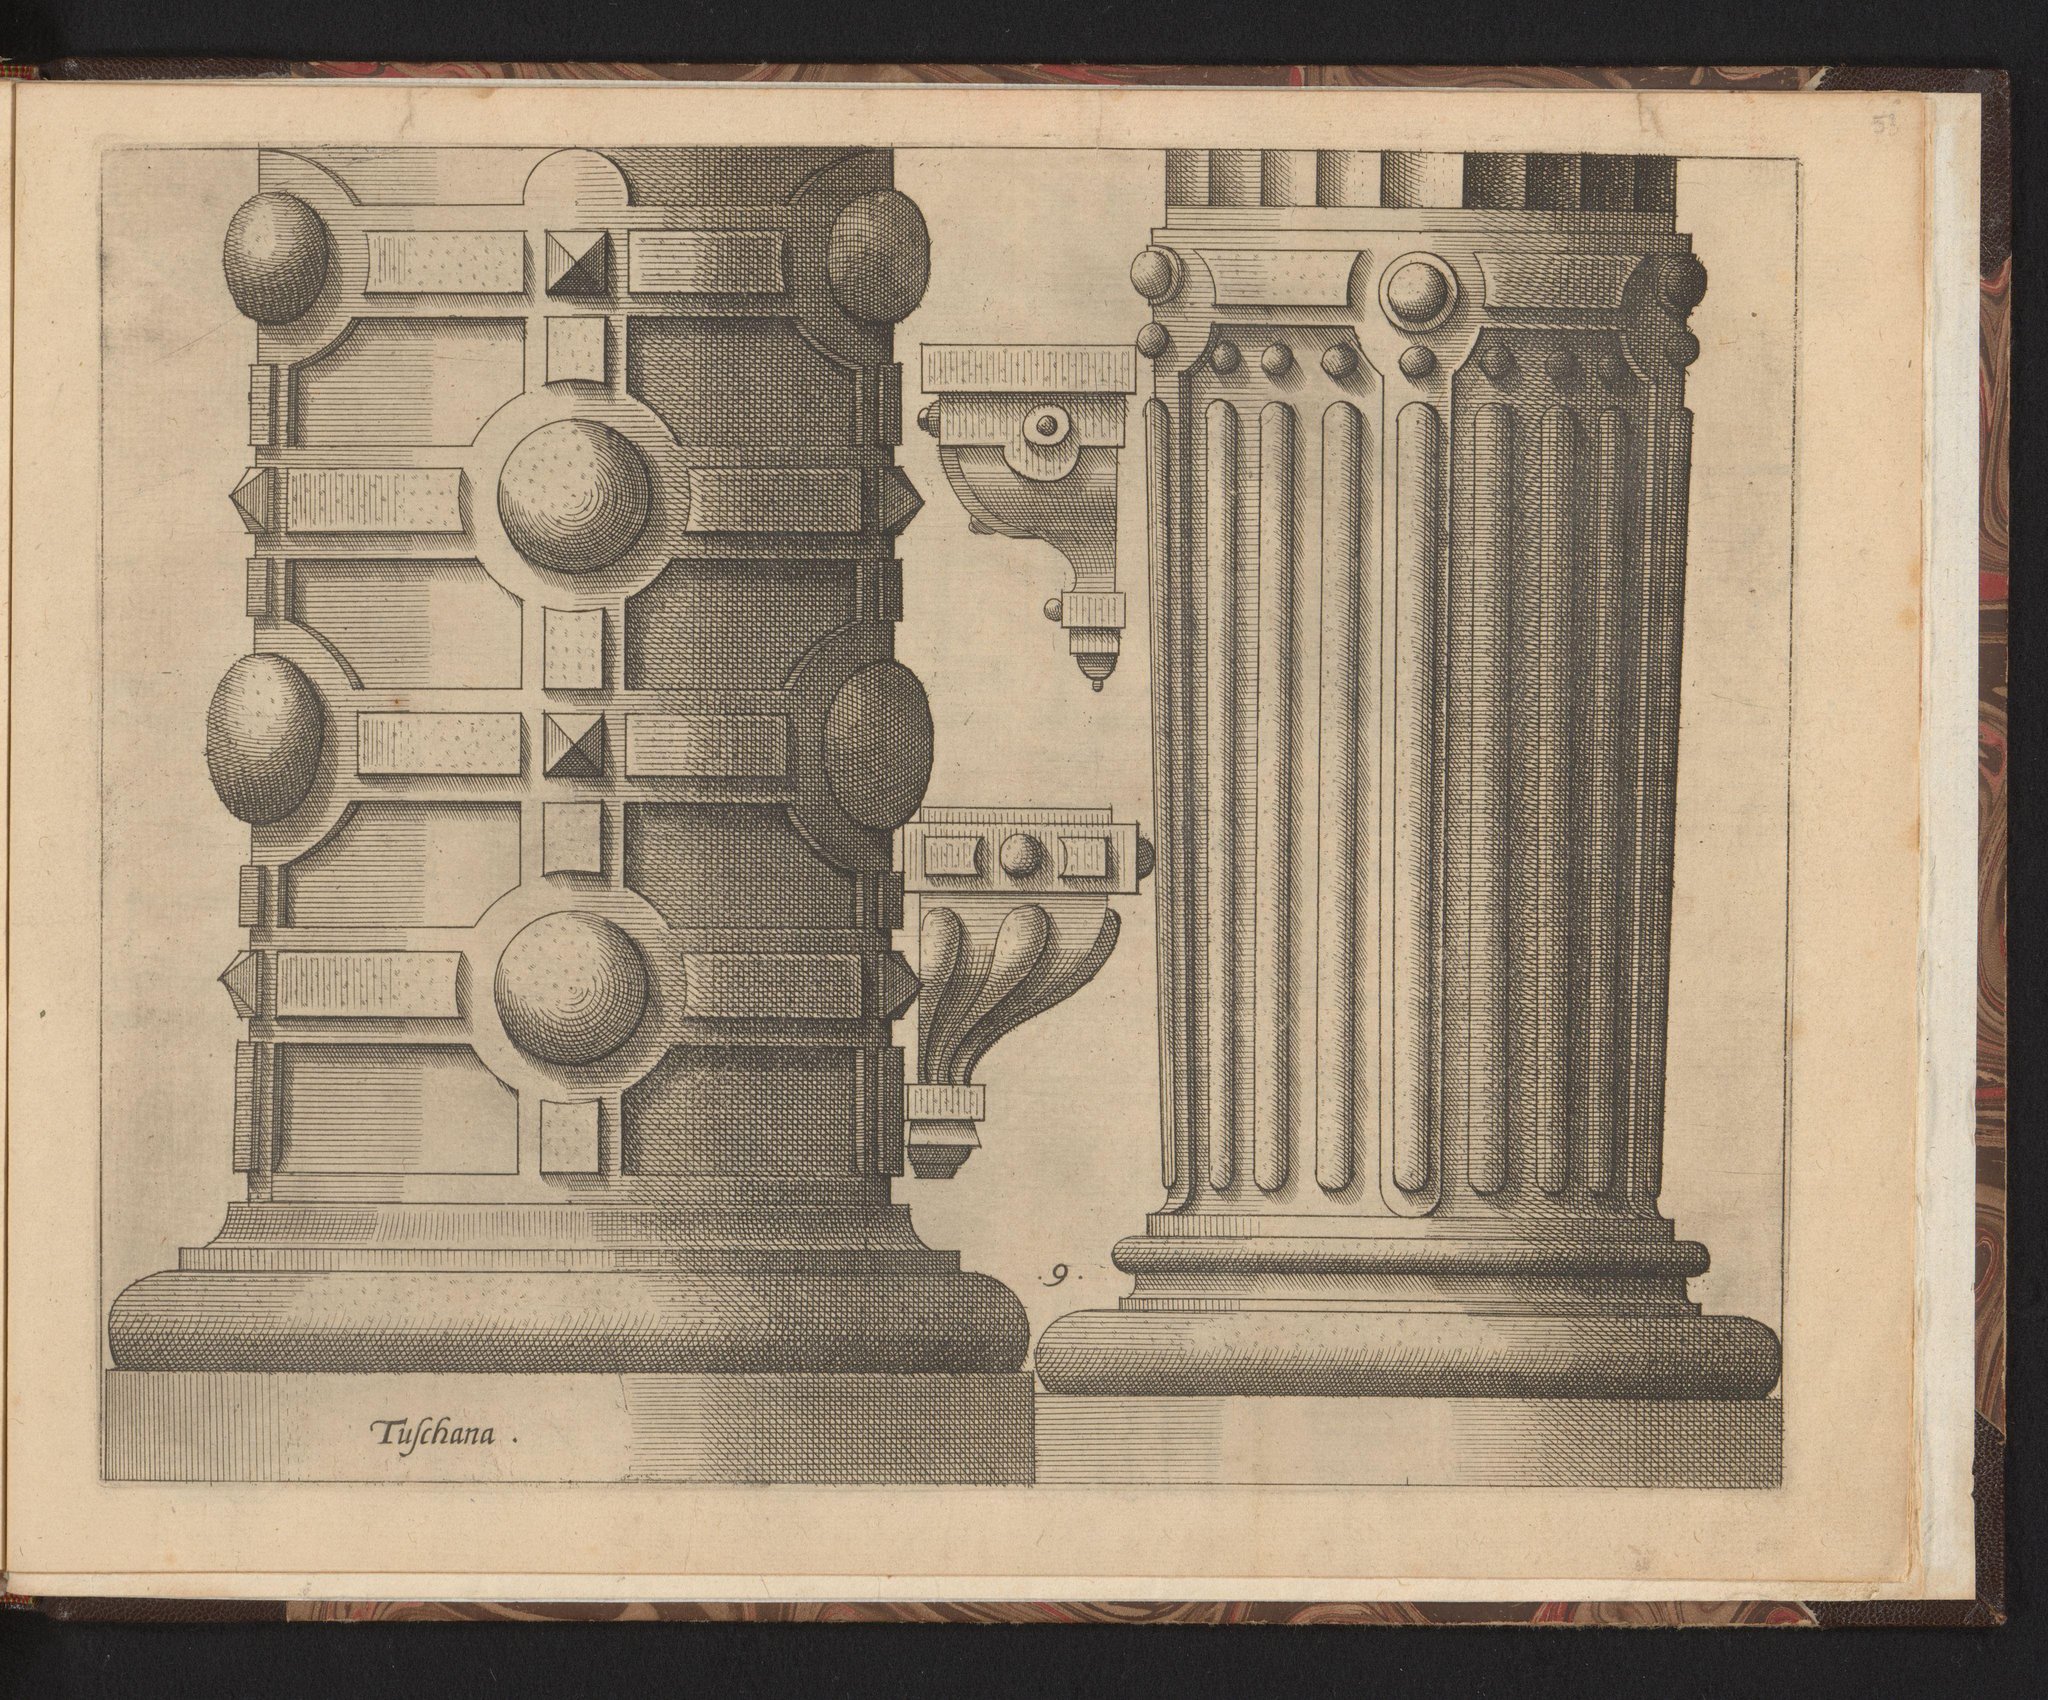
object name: print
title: Twee 'columnae caelatae' en twee consoles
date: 1578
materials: paper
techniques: etching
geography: antwerp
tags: column, pillar ~ architecture, tuscan order ~ architecture, other architectural details (console)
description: Twee 'columnae caelatae'. Links de onderste helft van een zuil met gestileerde bossage, diamantkoppen en halve bollen. Rechts een zuil met staafwerk. In het midden twee consoles. De prent maakt deel uit van een album.